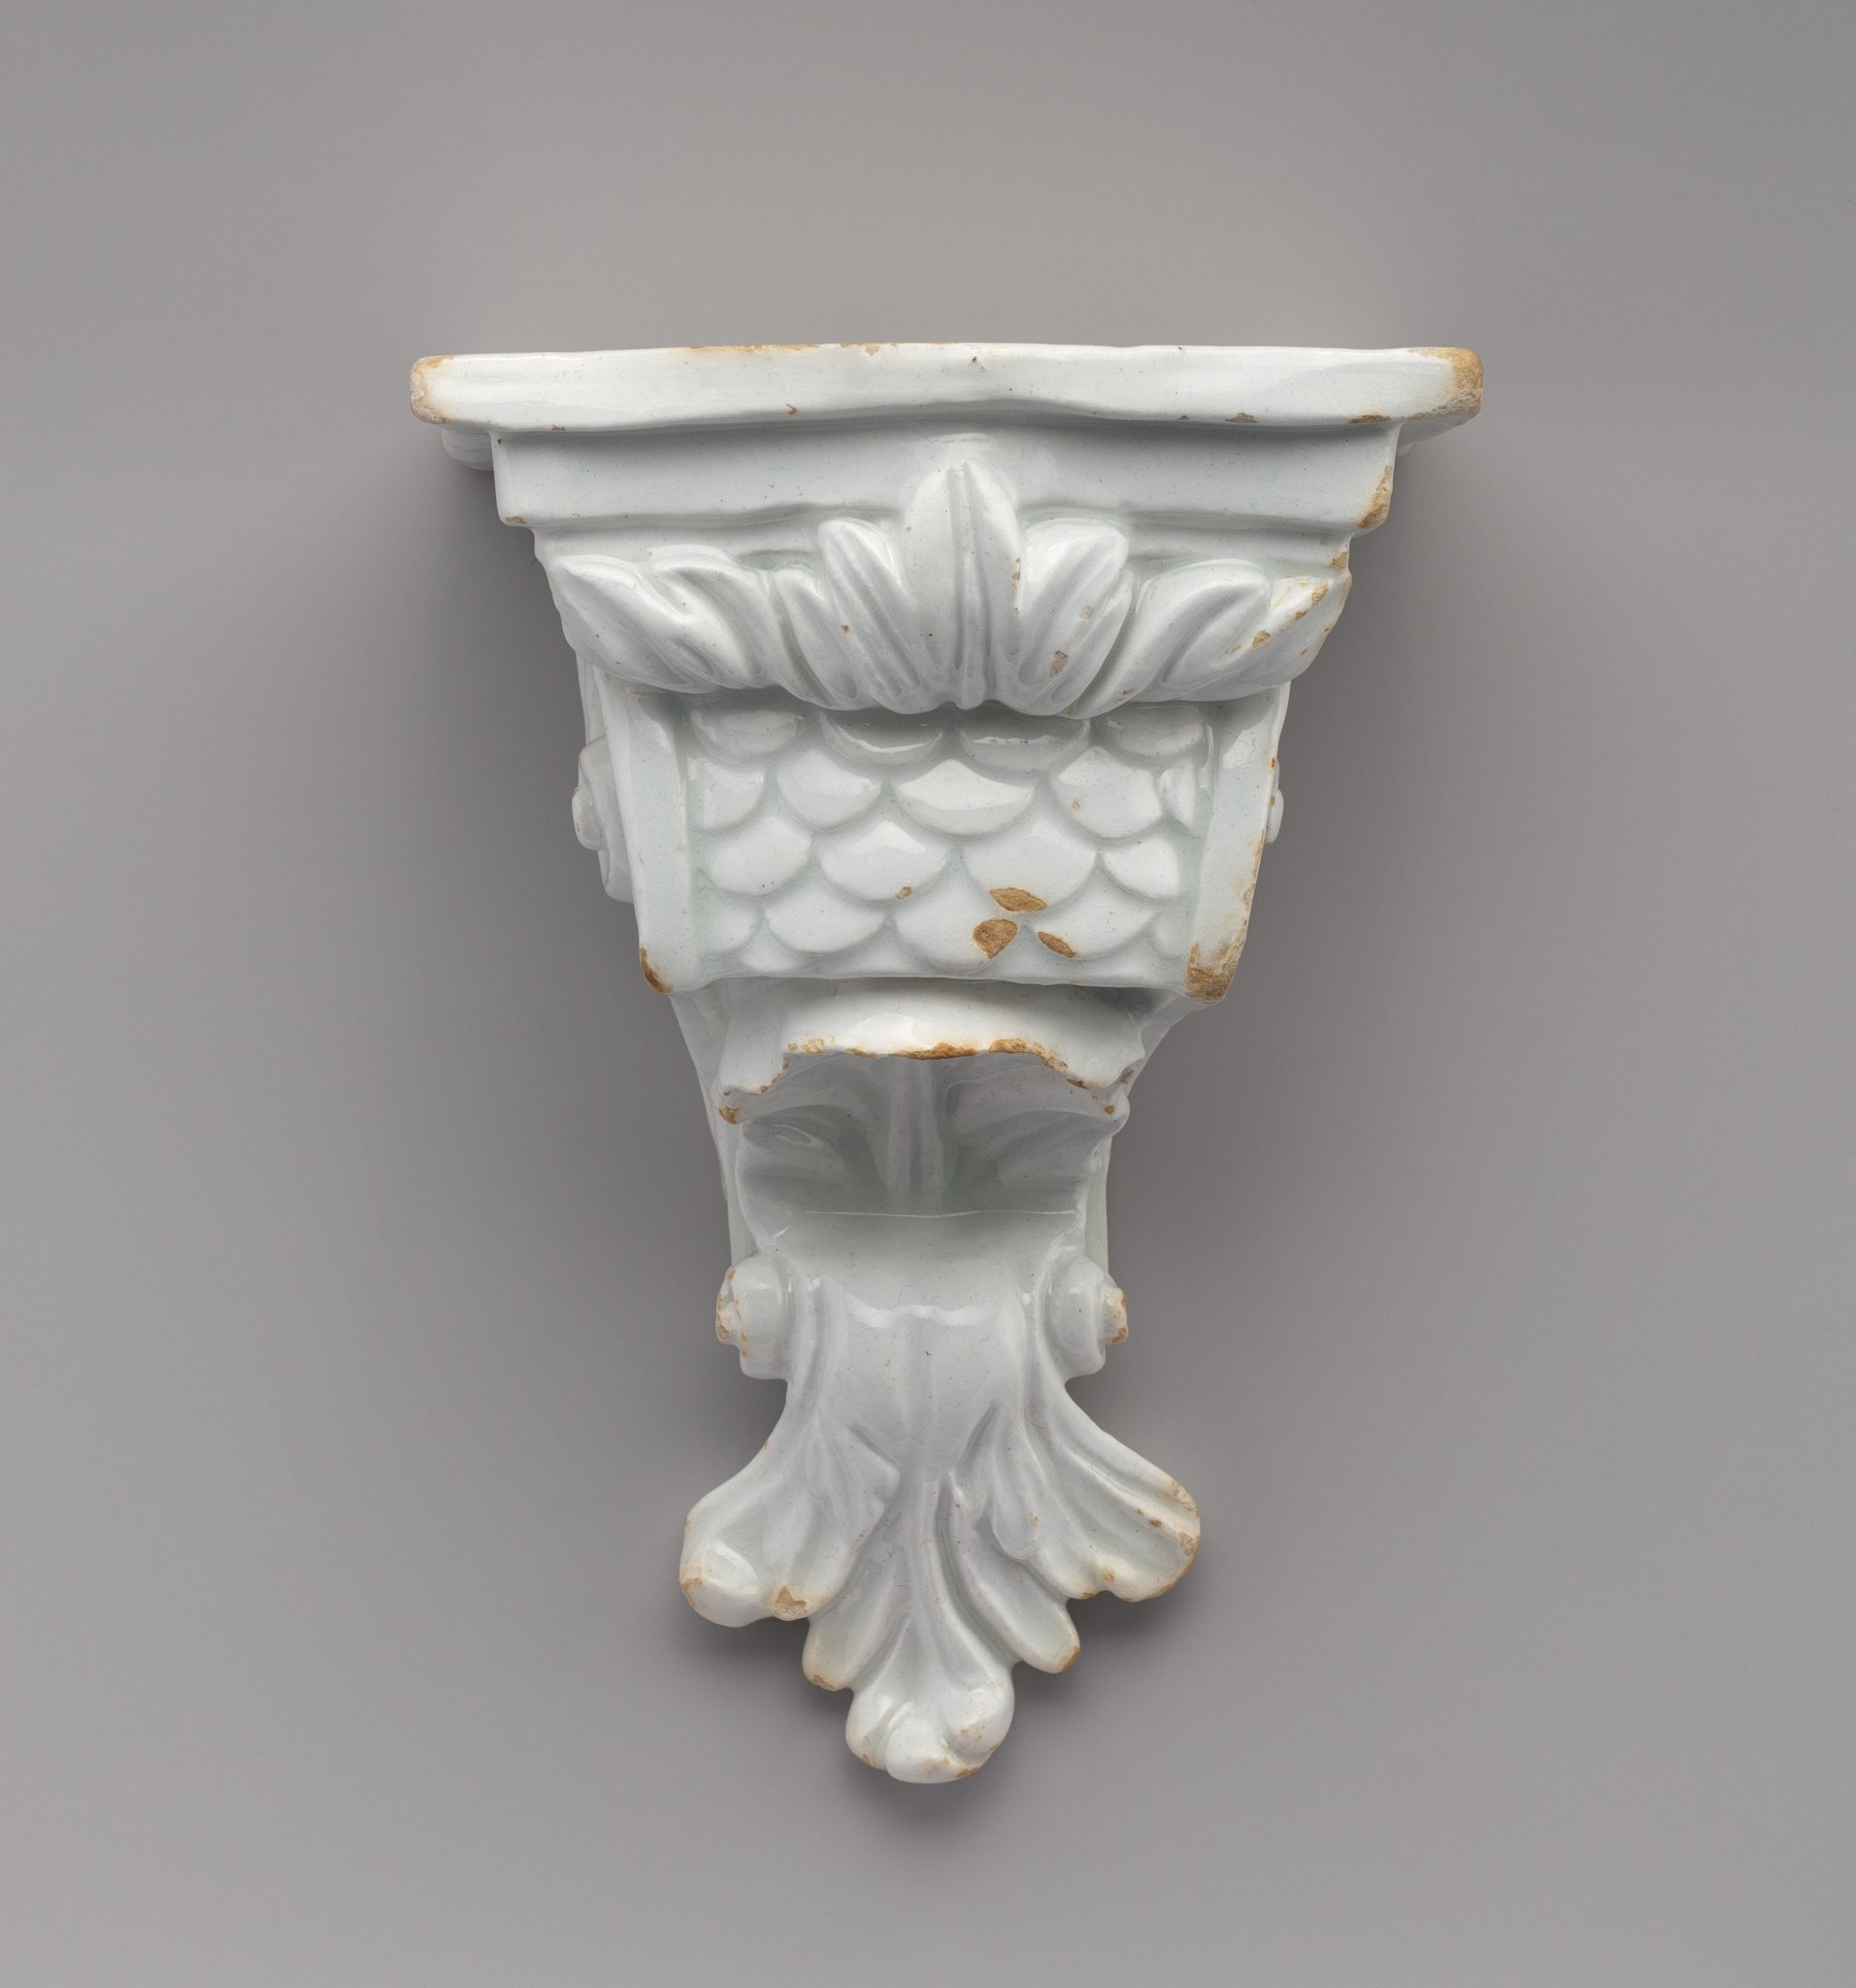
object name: wall bracket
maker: derby porcelain manufactory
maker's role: factory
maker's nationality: british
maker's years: 1751-1785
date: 1752-1755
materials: soft paste porcelain